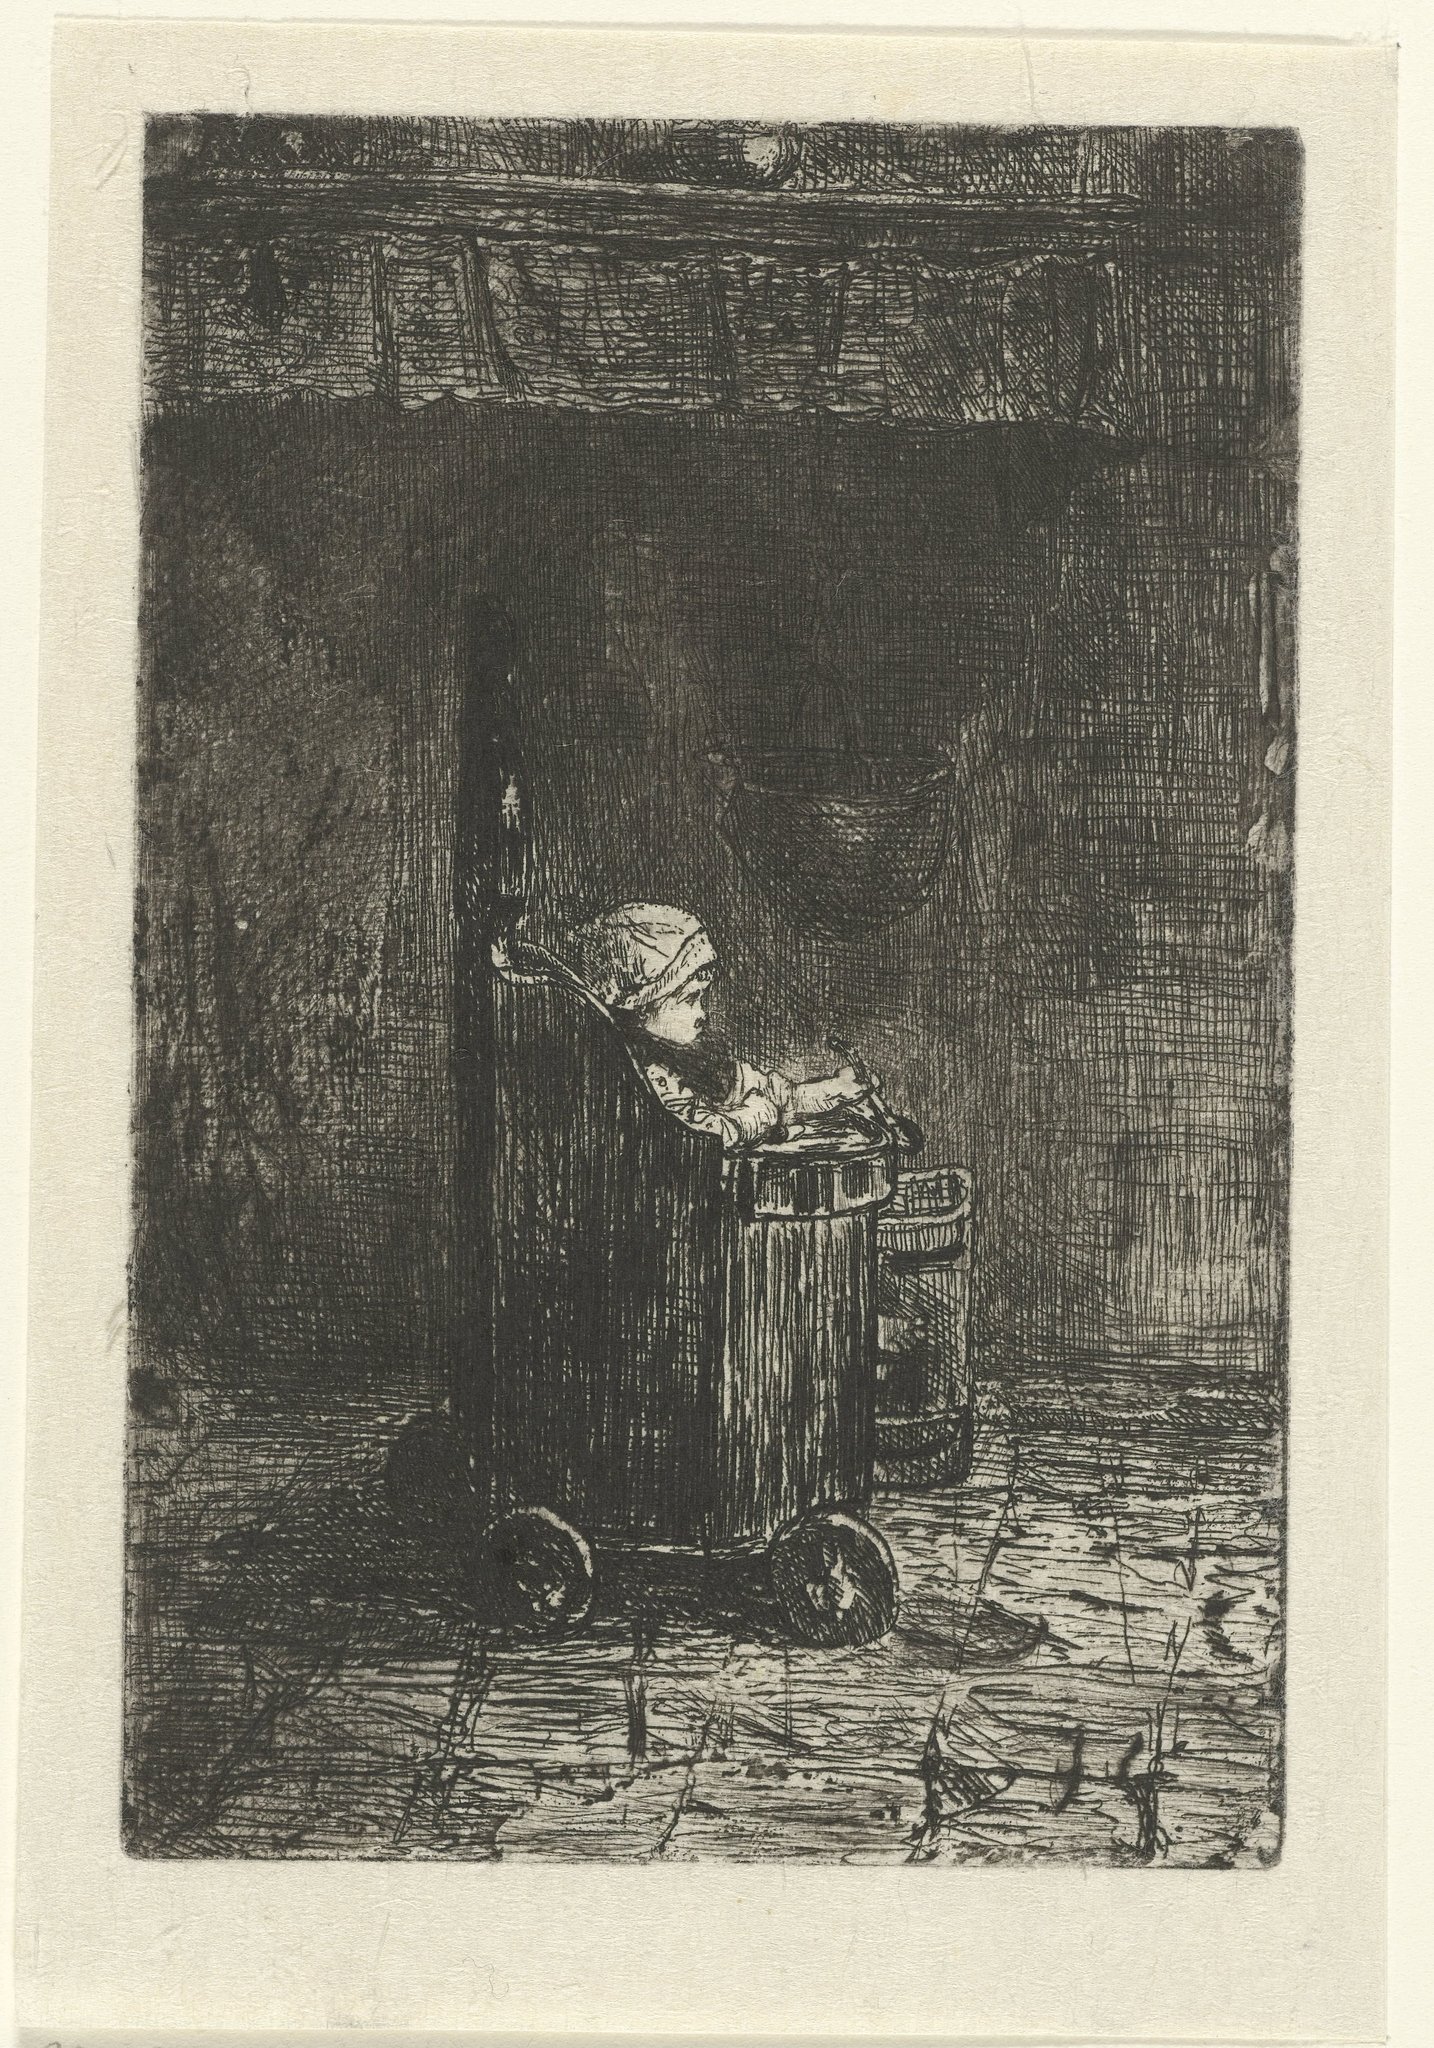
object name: print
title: Kind in de kinderstoel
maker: jozef israëls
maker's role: draughtsman, painter, print maker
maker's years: 1824-1911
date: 1835-1911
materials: paper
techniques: etching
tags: baby-chair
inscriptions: collector's mark: Lugt 2228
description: Een kind in een houten kinderstoel op wielen bij de schoorsteen.